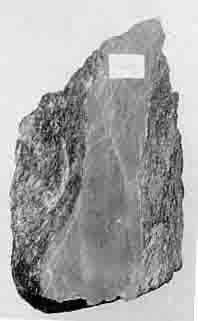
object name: fragment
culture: russian, siberia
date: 1902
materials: jade